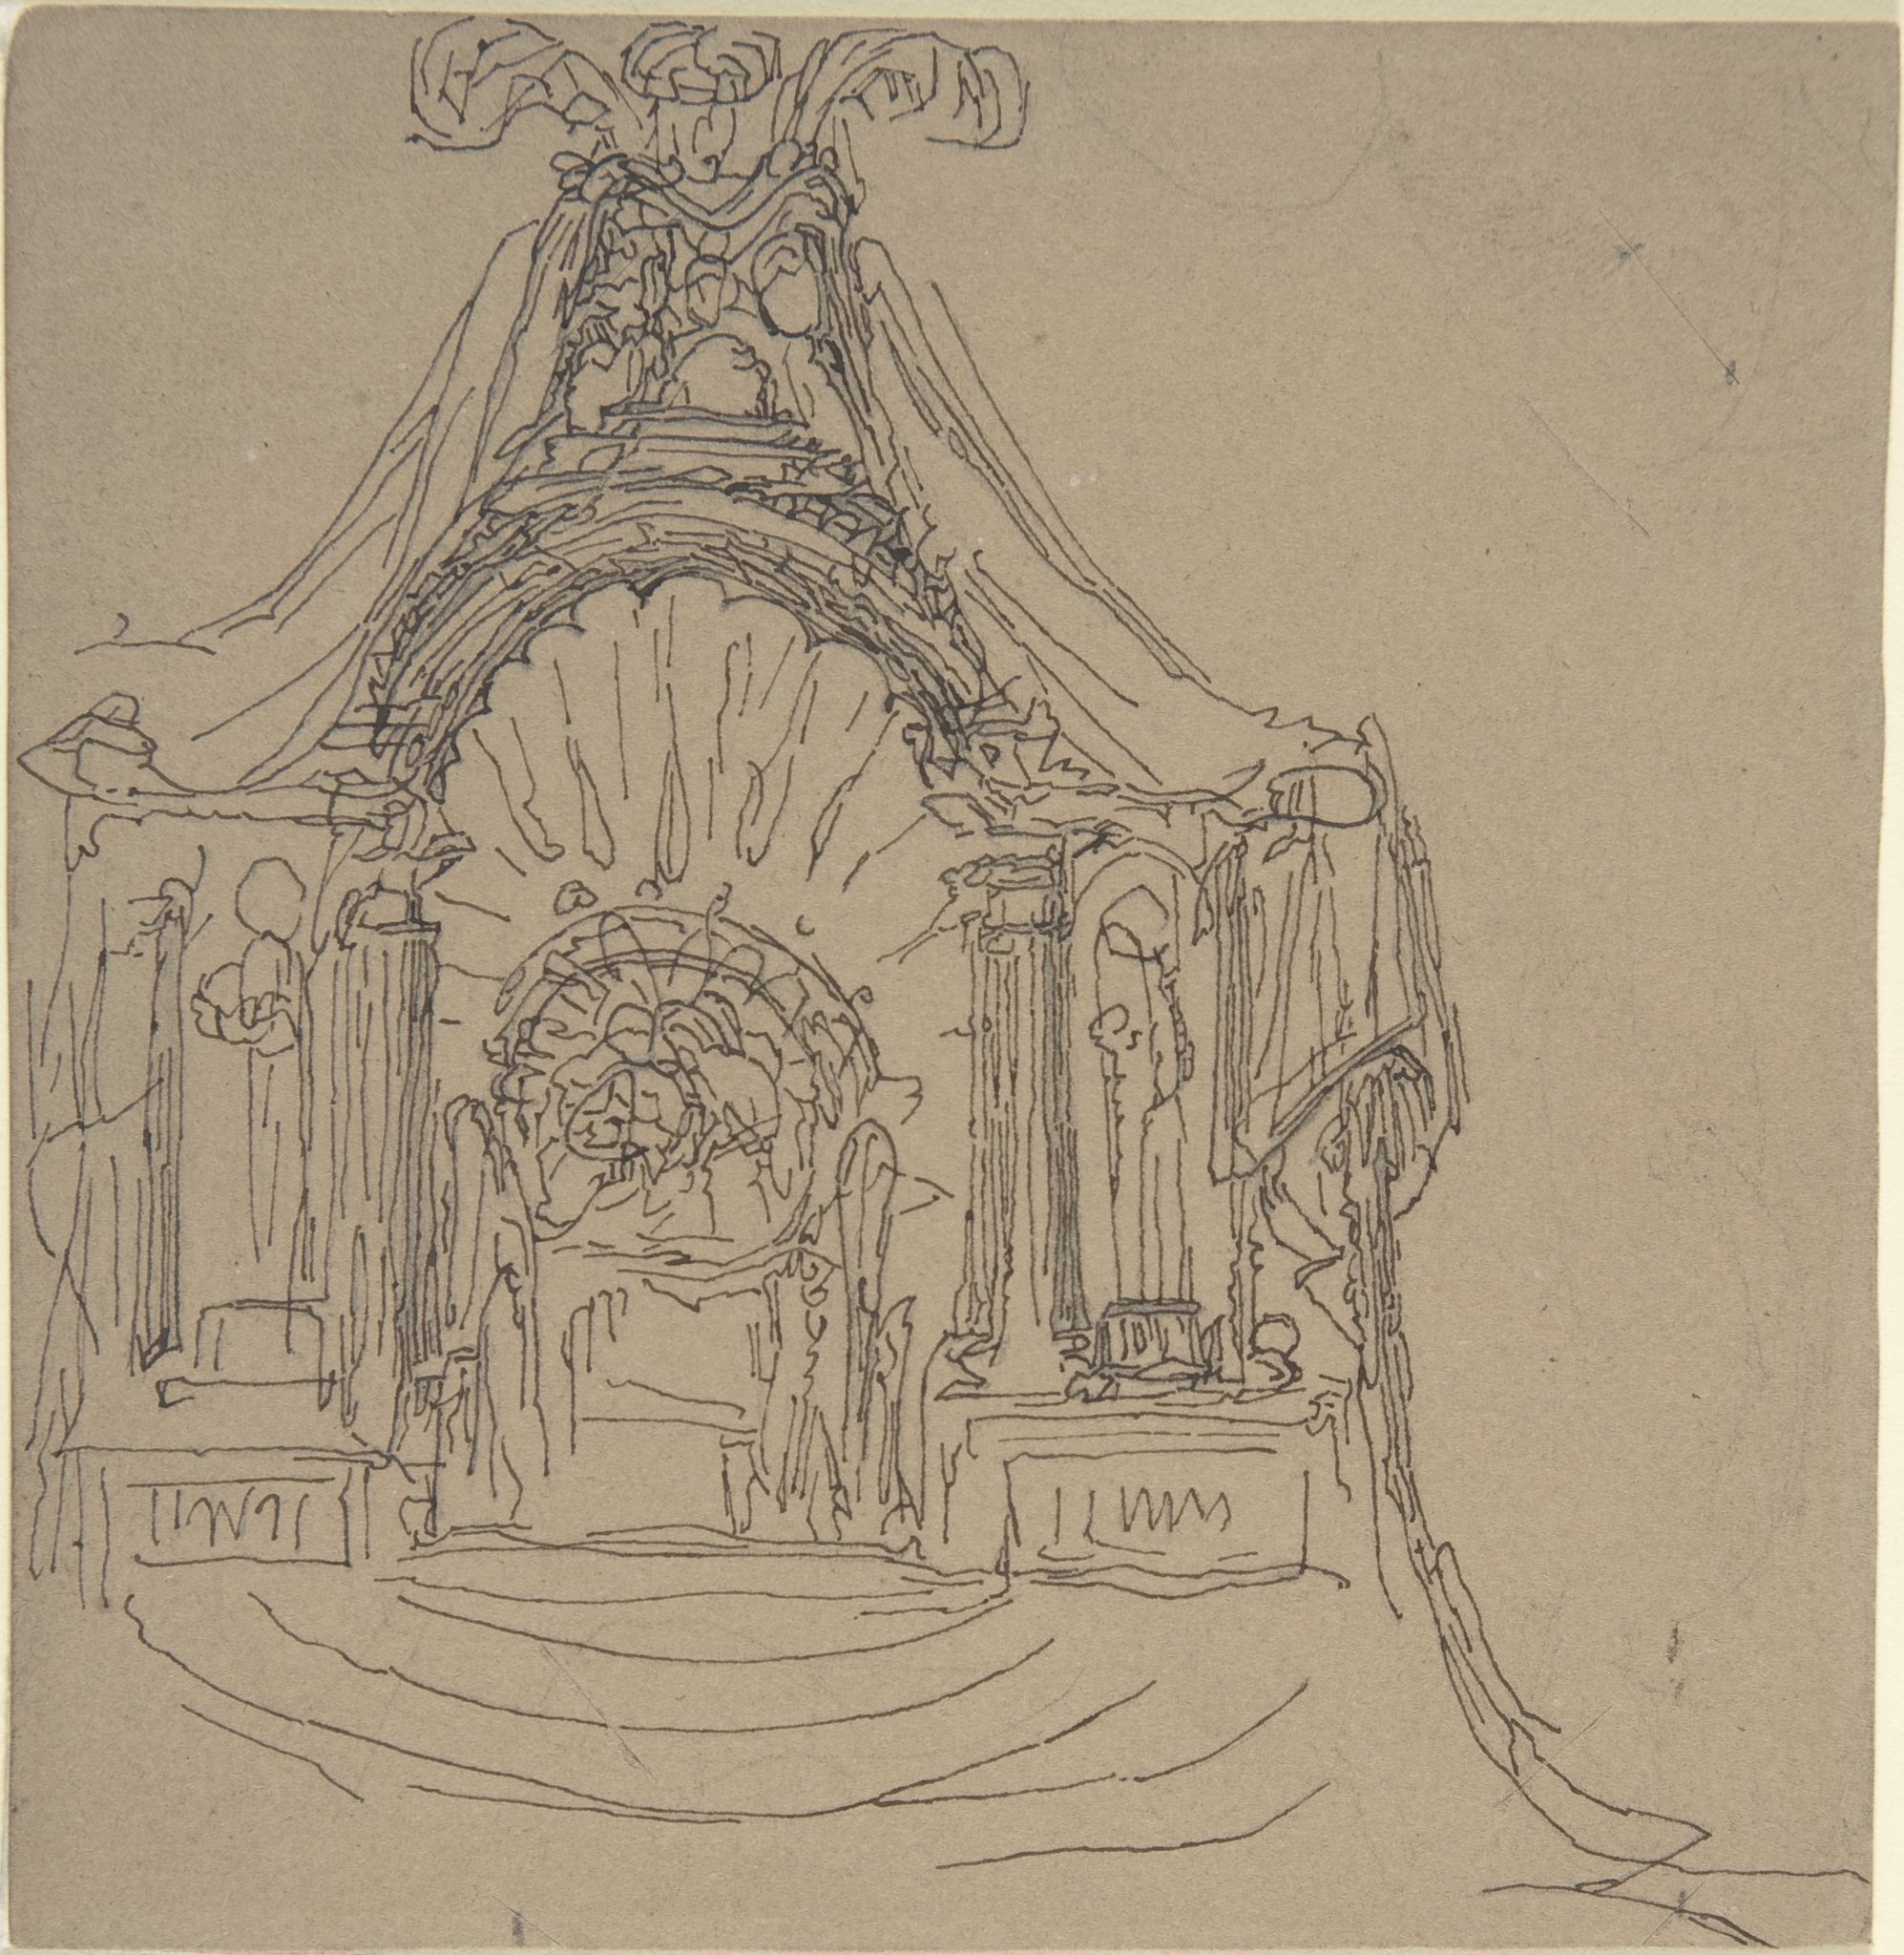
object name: drawing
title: Design for a Throne (recto); Recumbent Figure (verso)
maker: william pitts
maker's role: artist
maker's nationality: british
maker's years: 1790-1840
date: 1805-1840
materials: graphite, ink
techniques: pen